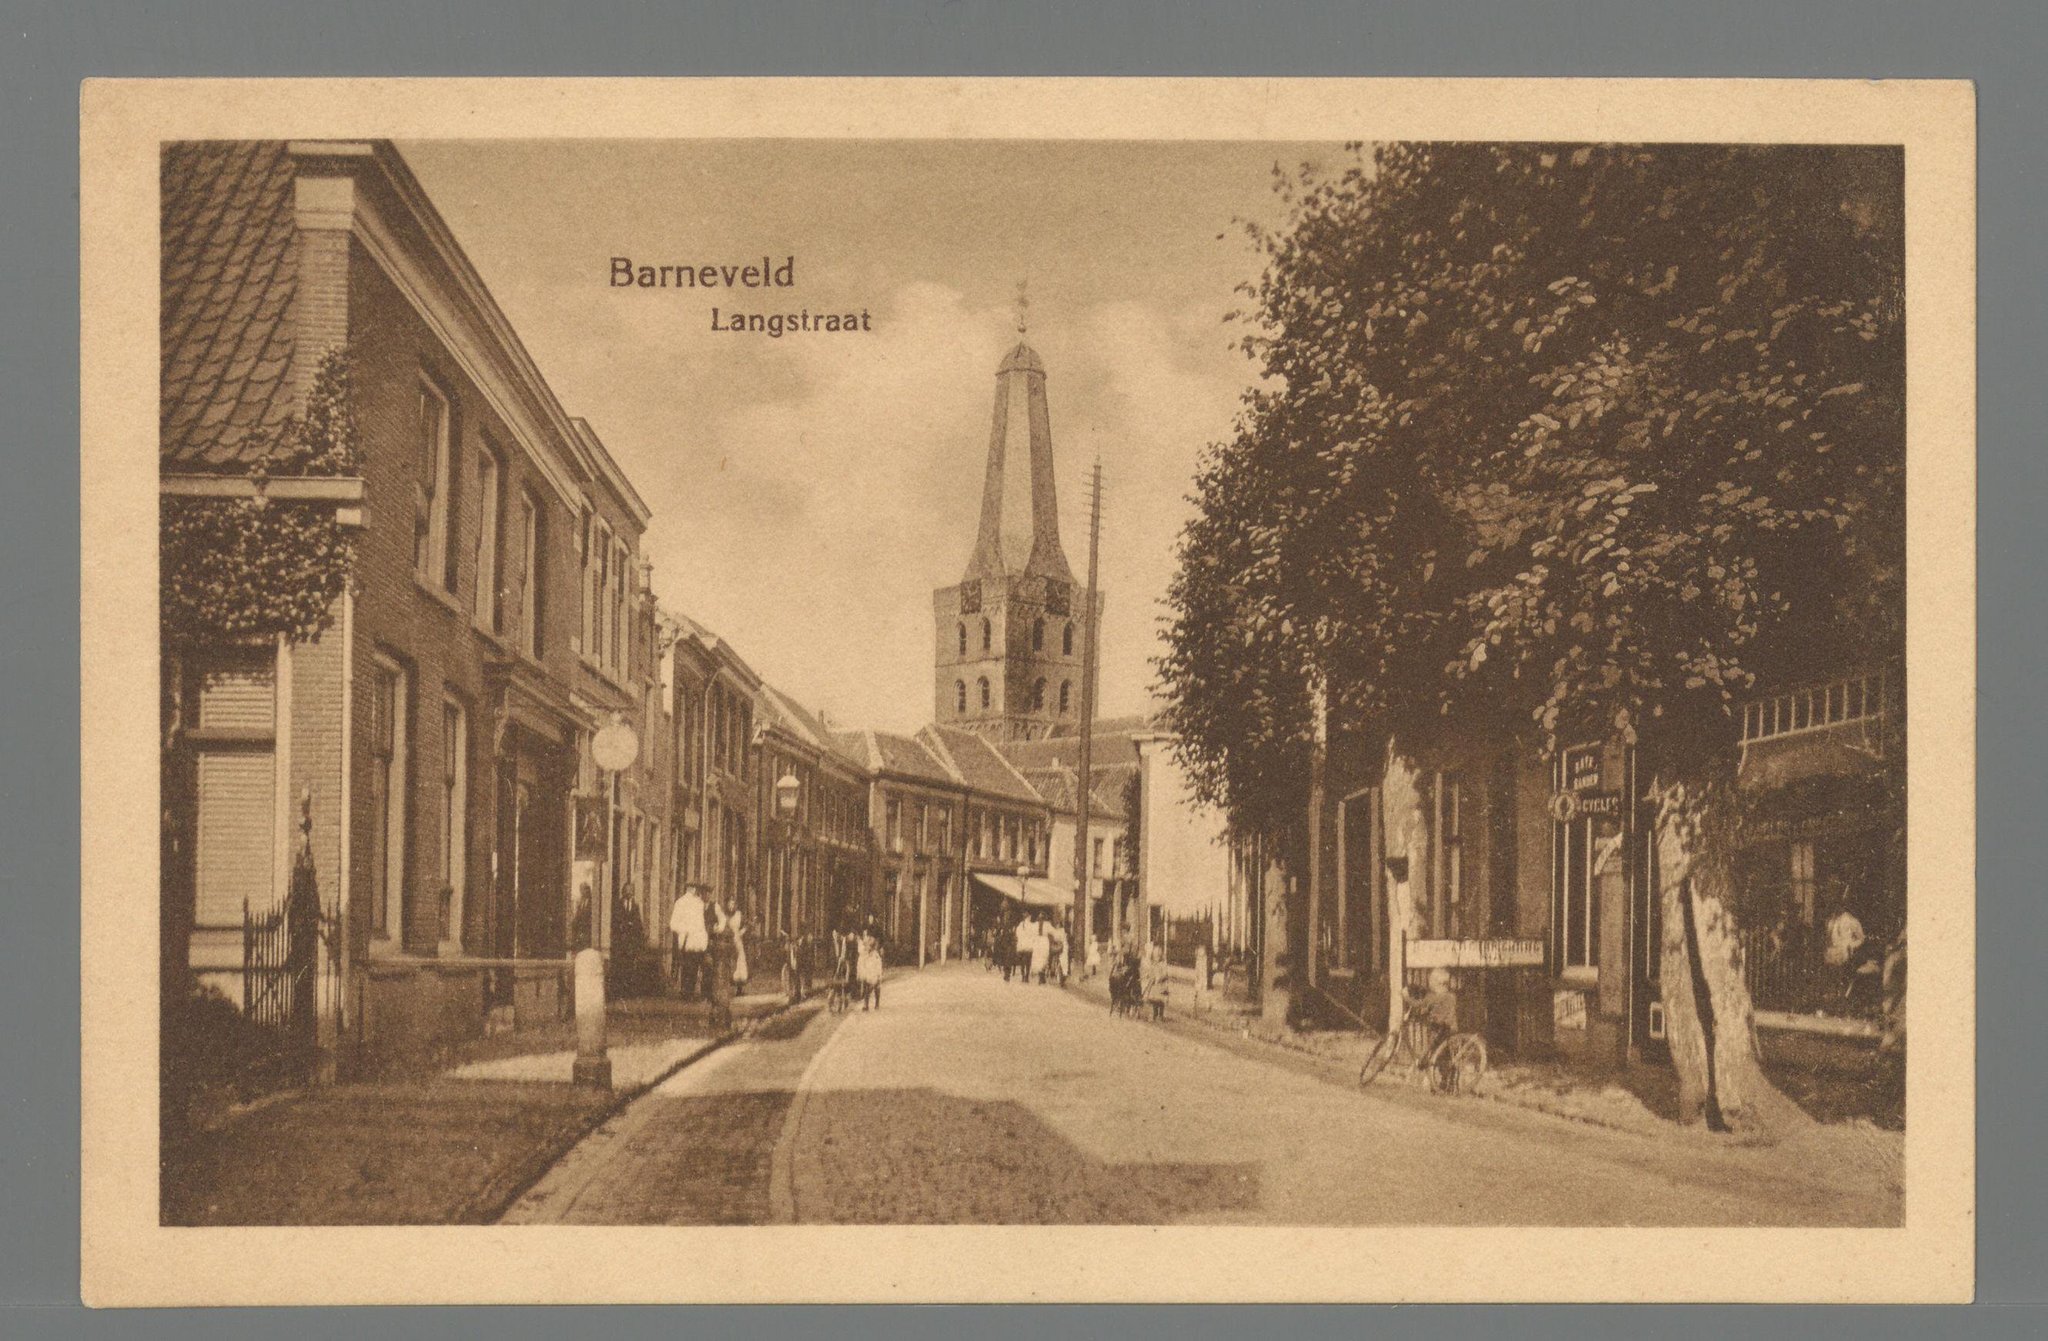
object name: photomechanical print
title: Barneveld. Langstraat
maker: Anonymous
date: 1922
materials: cardboard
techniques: photograph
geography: barneveld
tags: church (exterior), street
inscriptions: date